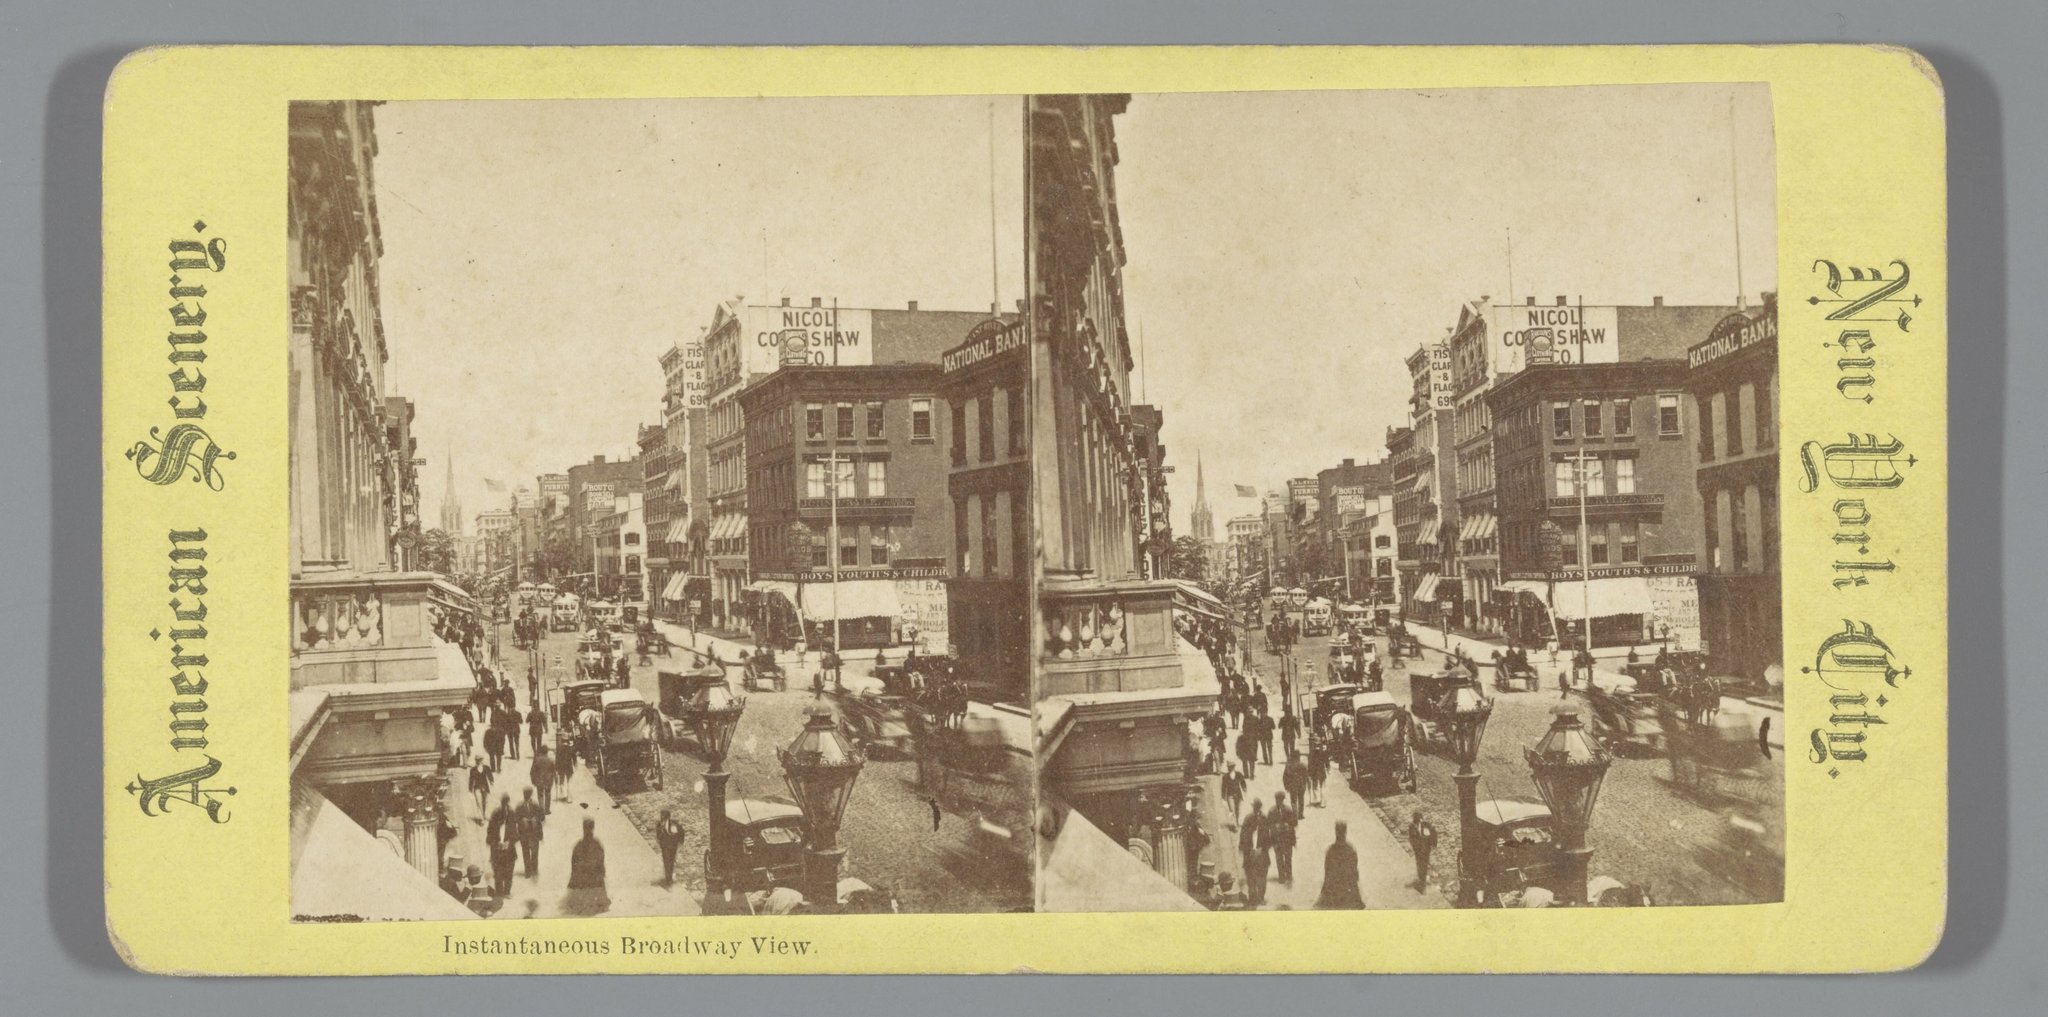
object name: stereograph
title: American Scenery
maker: Anonymous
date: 1868-1890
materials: cardboard, paper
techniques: albumen print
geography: new york city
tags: city-view in general; 'veduta'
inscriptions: inscription: ‘P’, title: ‘Broadway View’